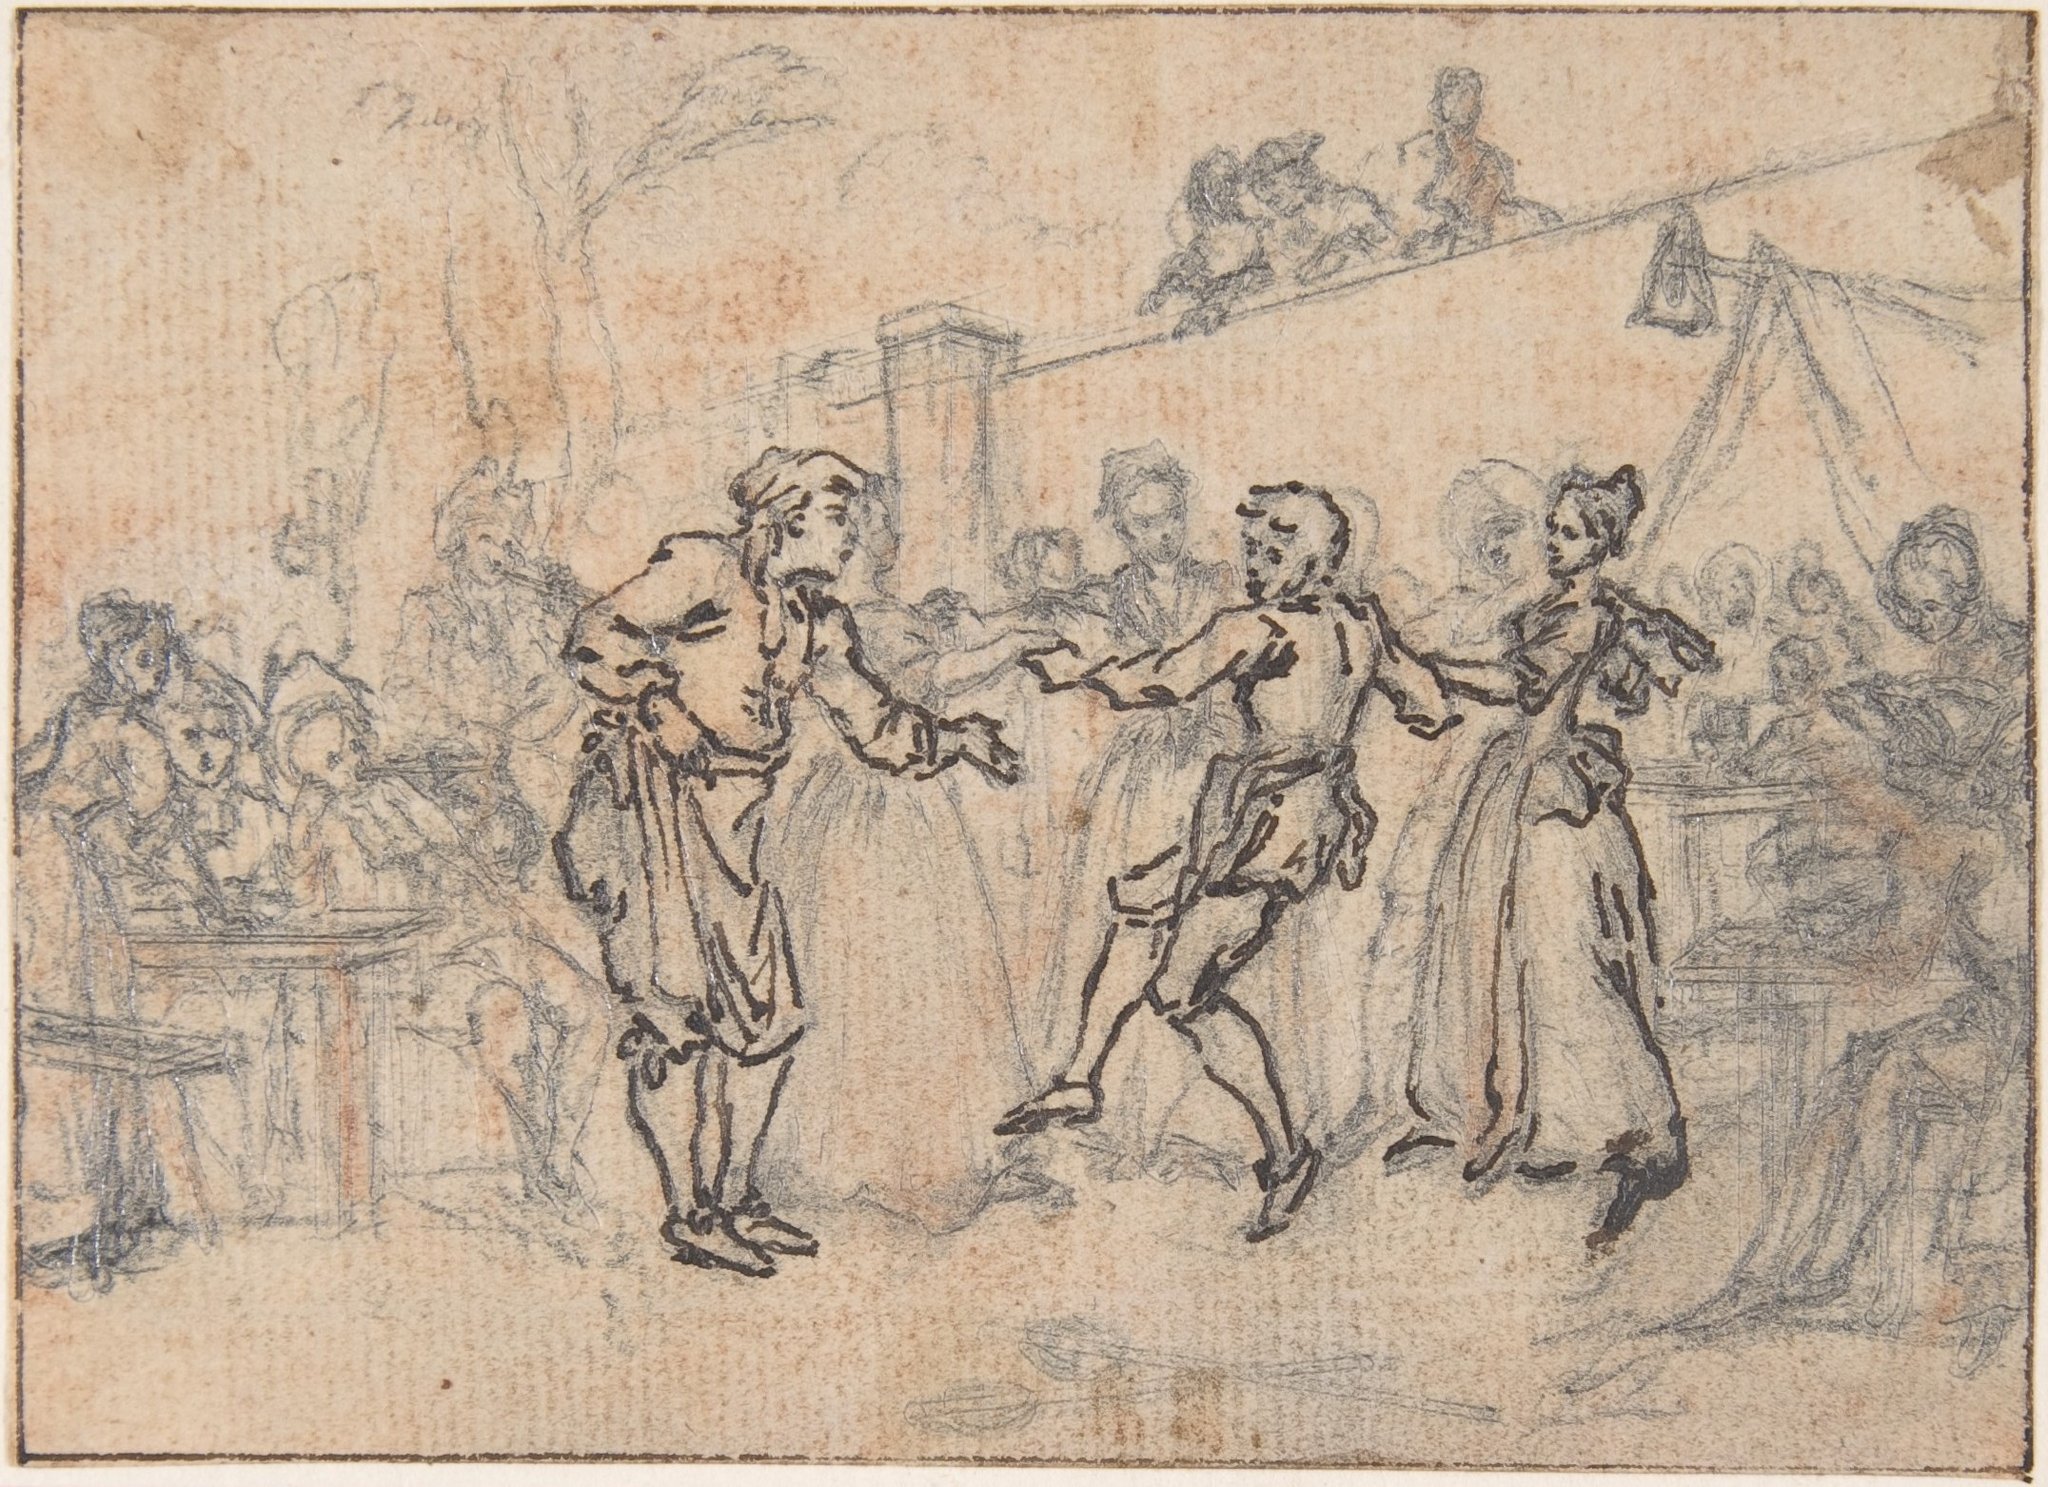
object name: drawing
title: Study for "Hob Continues Dancing in Spite of his Father," etched vignette in "Songs in the Opera of Flora"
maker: hubert françois gravelot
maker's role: artist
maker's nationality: french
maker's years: 1699-1773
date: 1701-1800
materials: chalk, graphite, ink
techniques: pen, drawing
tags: men,women,dancing